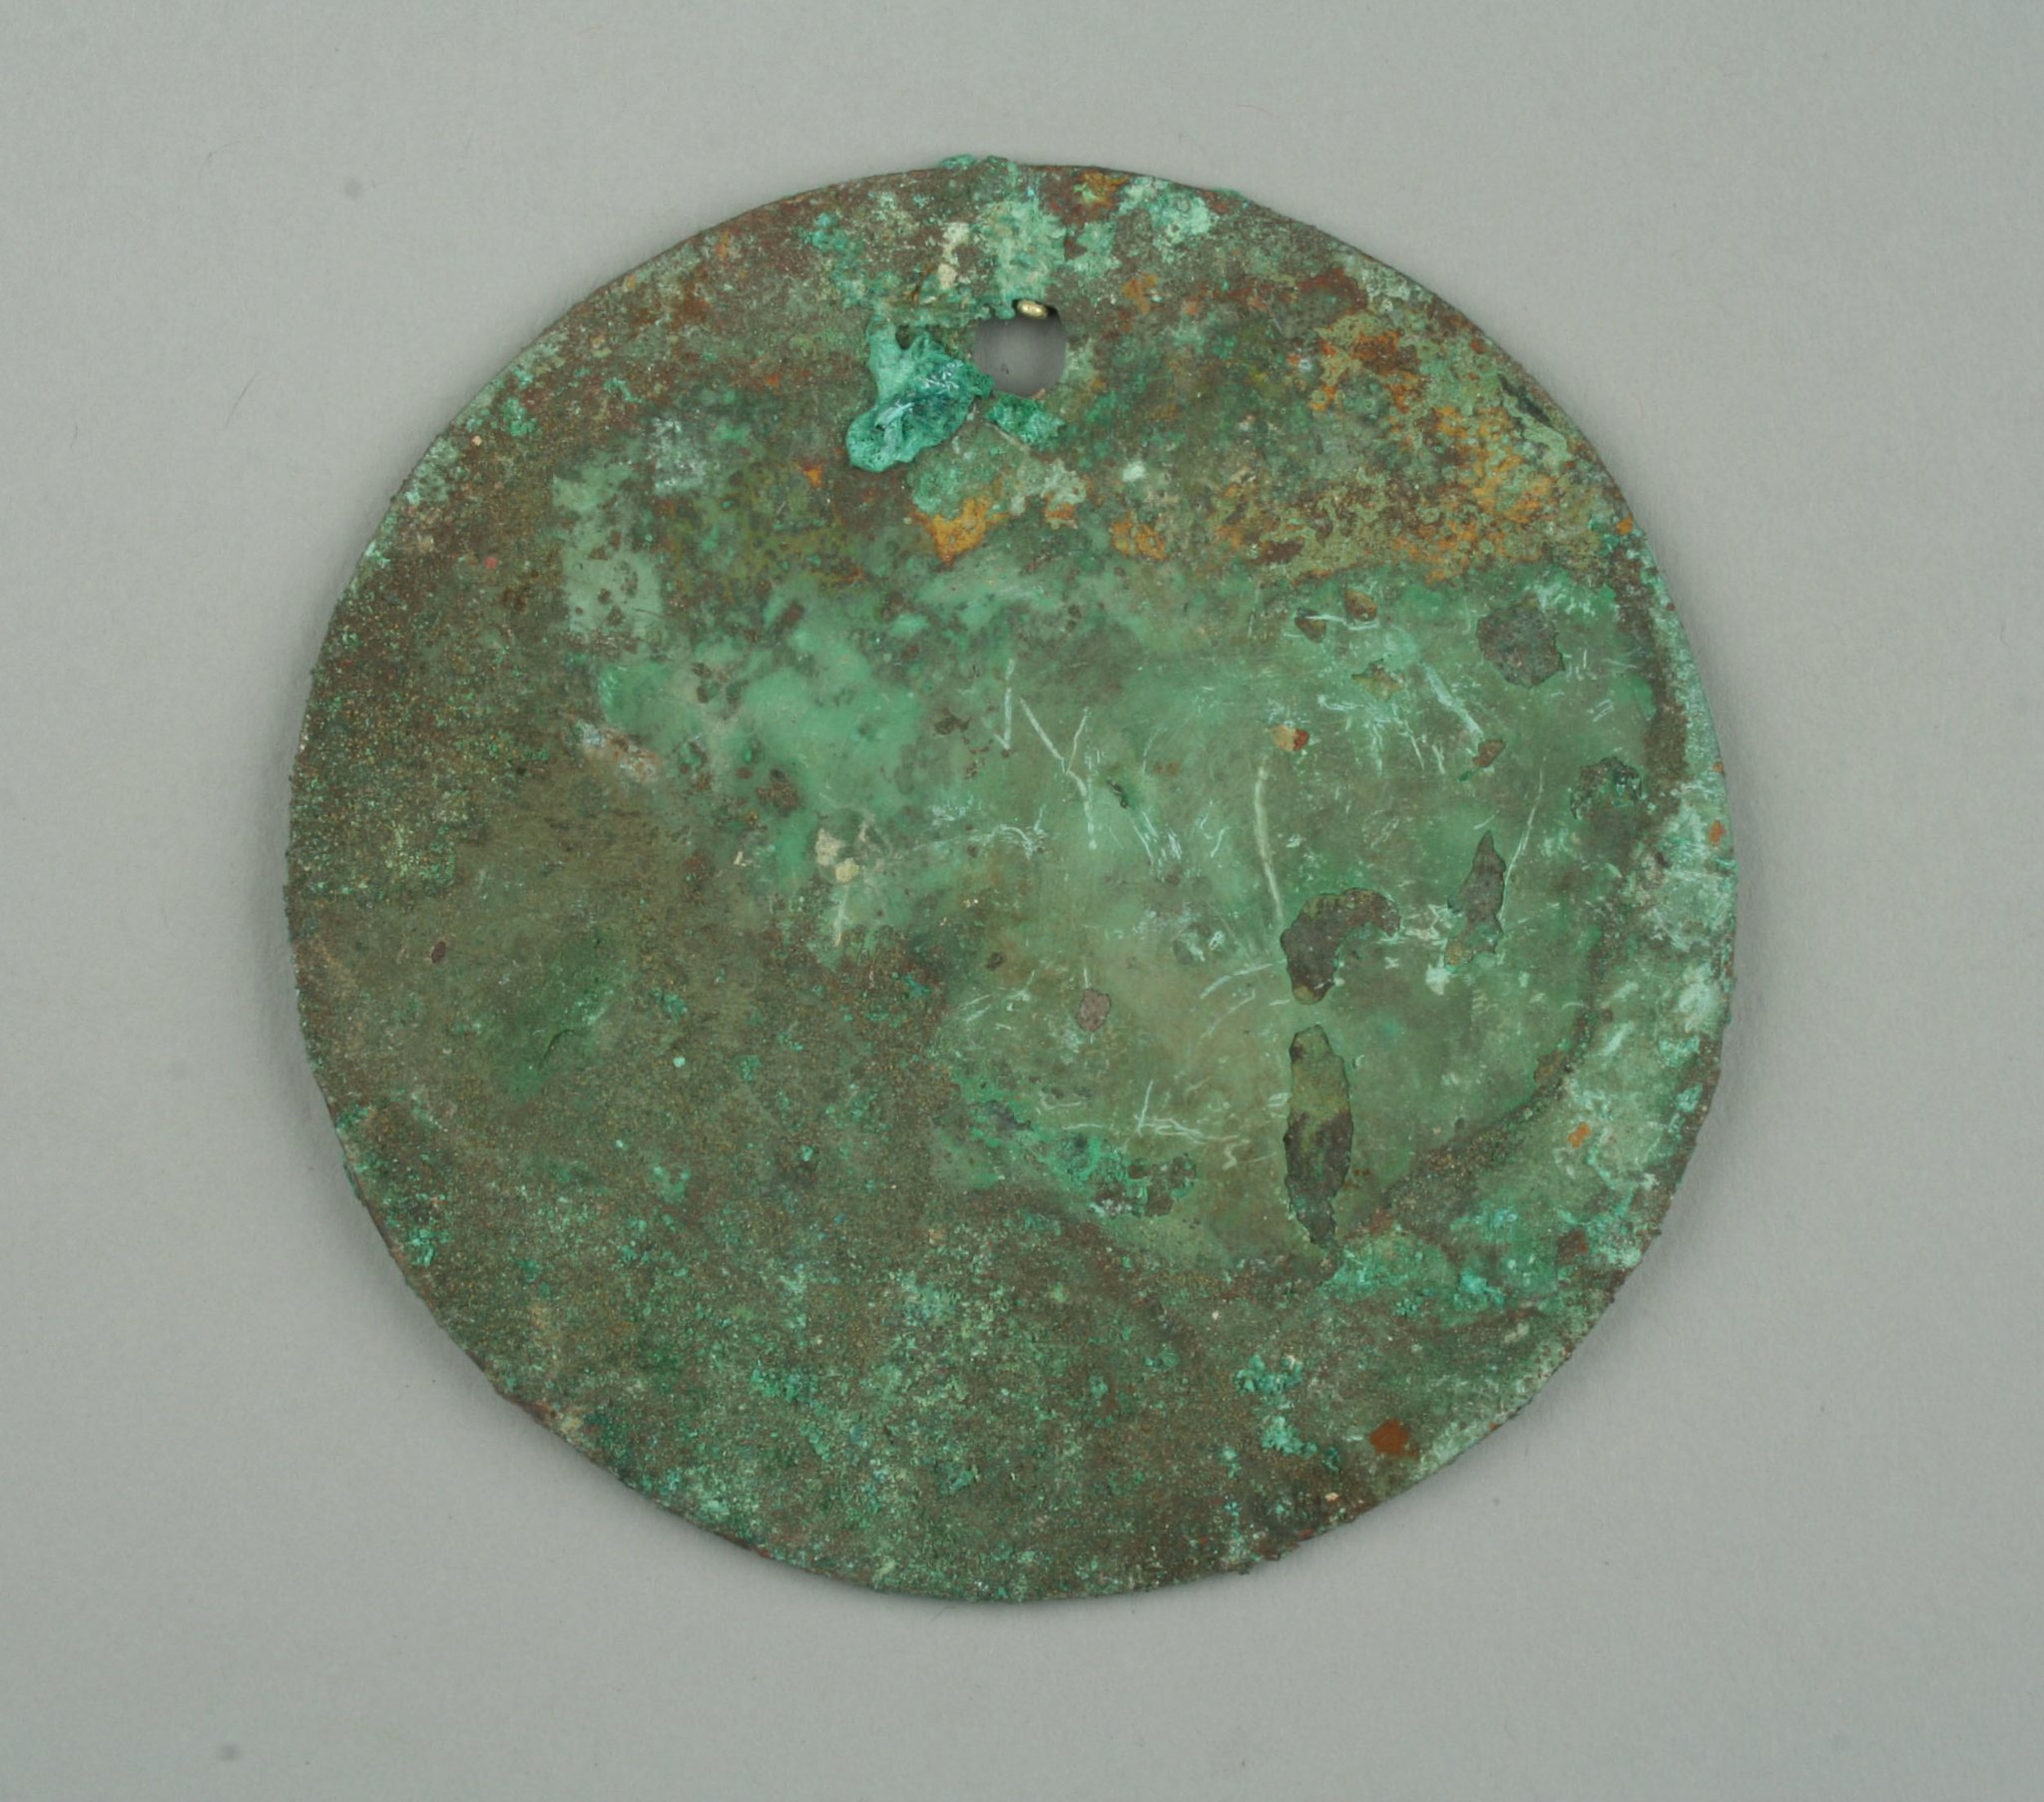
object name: plaque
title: Round Plaque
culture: vicús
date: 300 BCE-200 CE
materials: copper, gilt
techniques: hammering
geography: peru